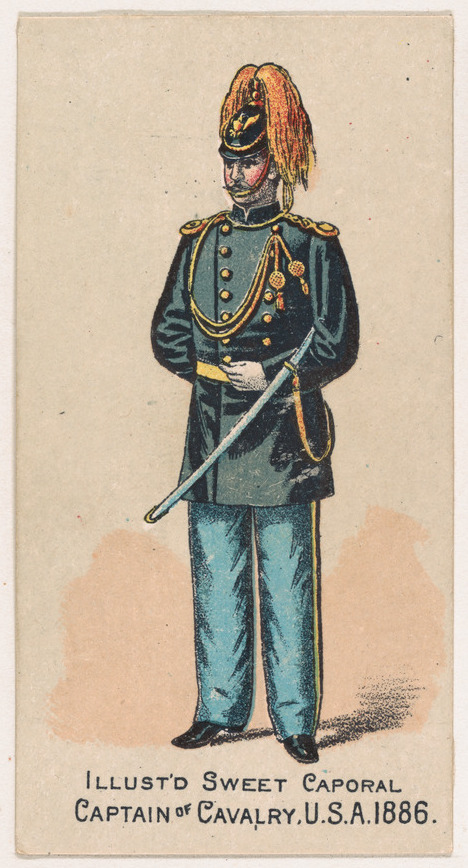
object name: print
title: Captain of Cavalry, United States Army, 1886, from the Military Series (N224) issued by Kinney Tobacco Company to promote Sweet Caporal Cigarettes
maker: kinney brothers tobacco company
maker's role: publisher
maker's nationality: american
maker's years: 1869-2011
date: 1888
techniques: color lithograph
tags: military,men